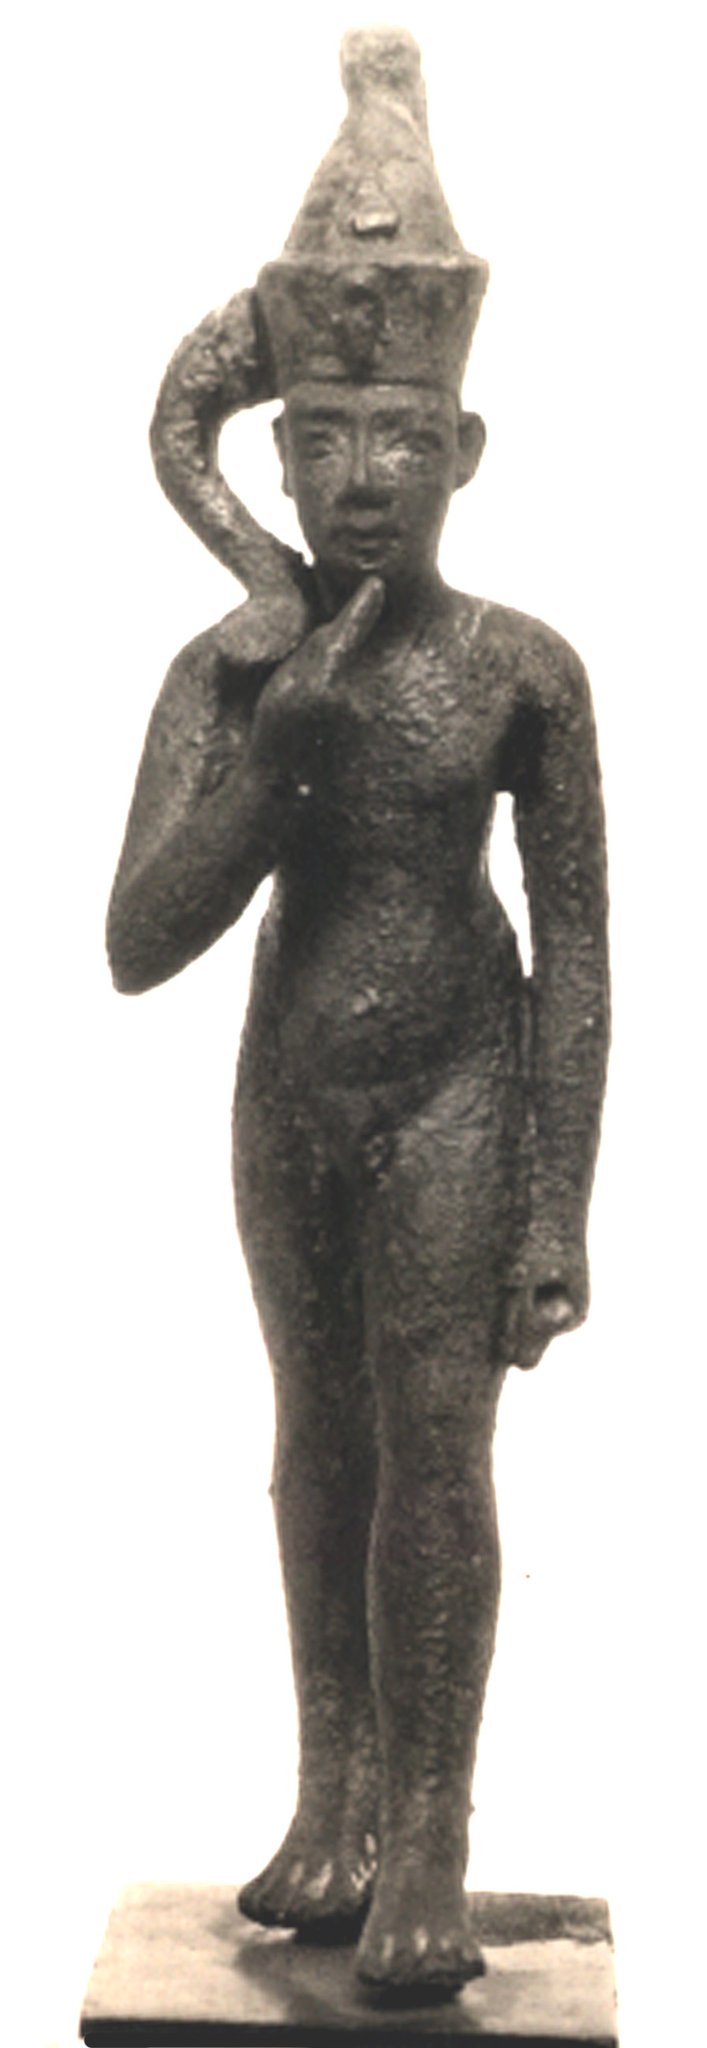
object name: statuette, harpokrates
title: Statuette of Harpokrates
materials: bronze, copper alloy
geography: egypt